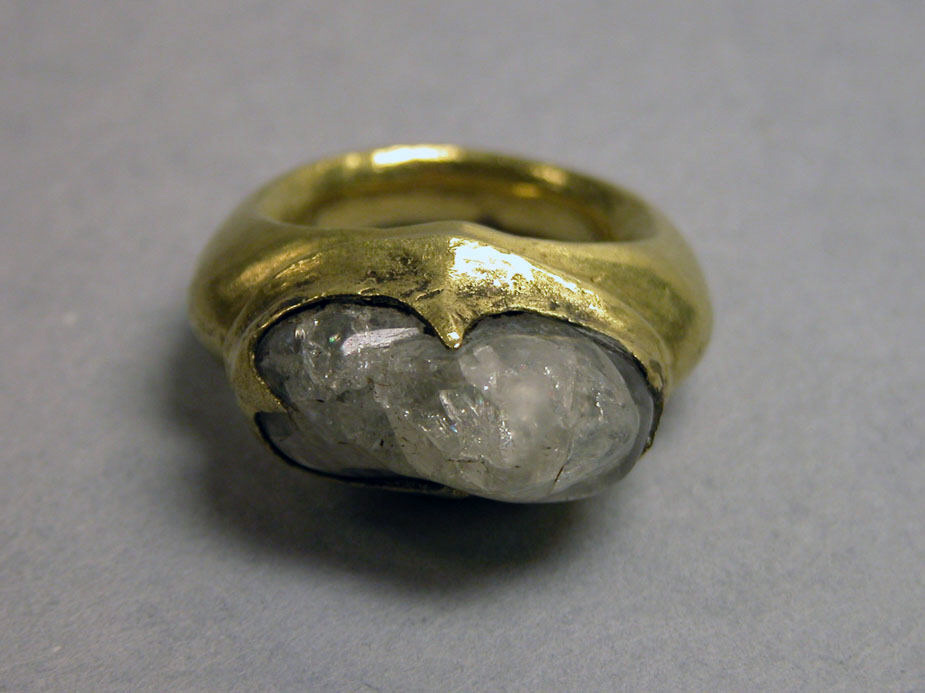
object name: ring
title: Ring with Inset Clear Stone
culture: indonesian, javanese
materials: gold, stone